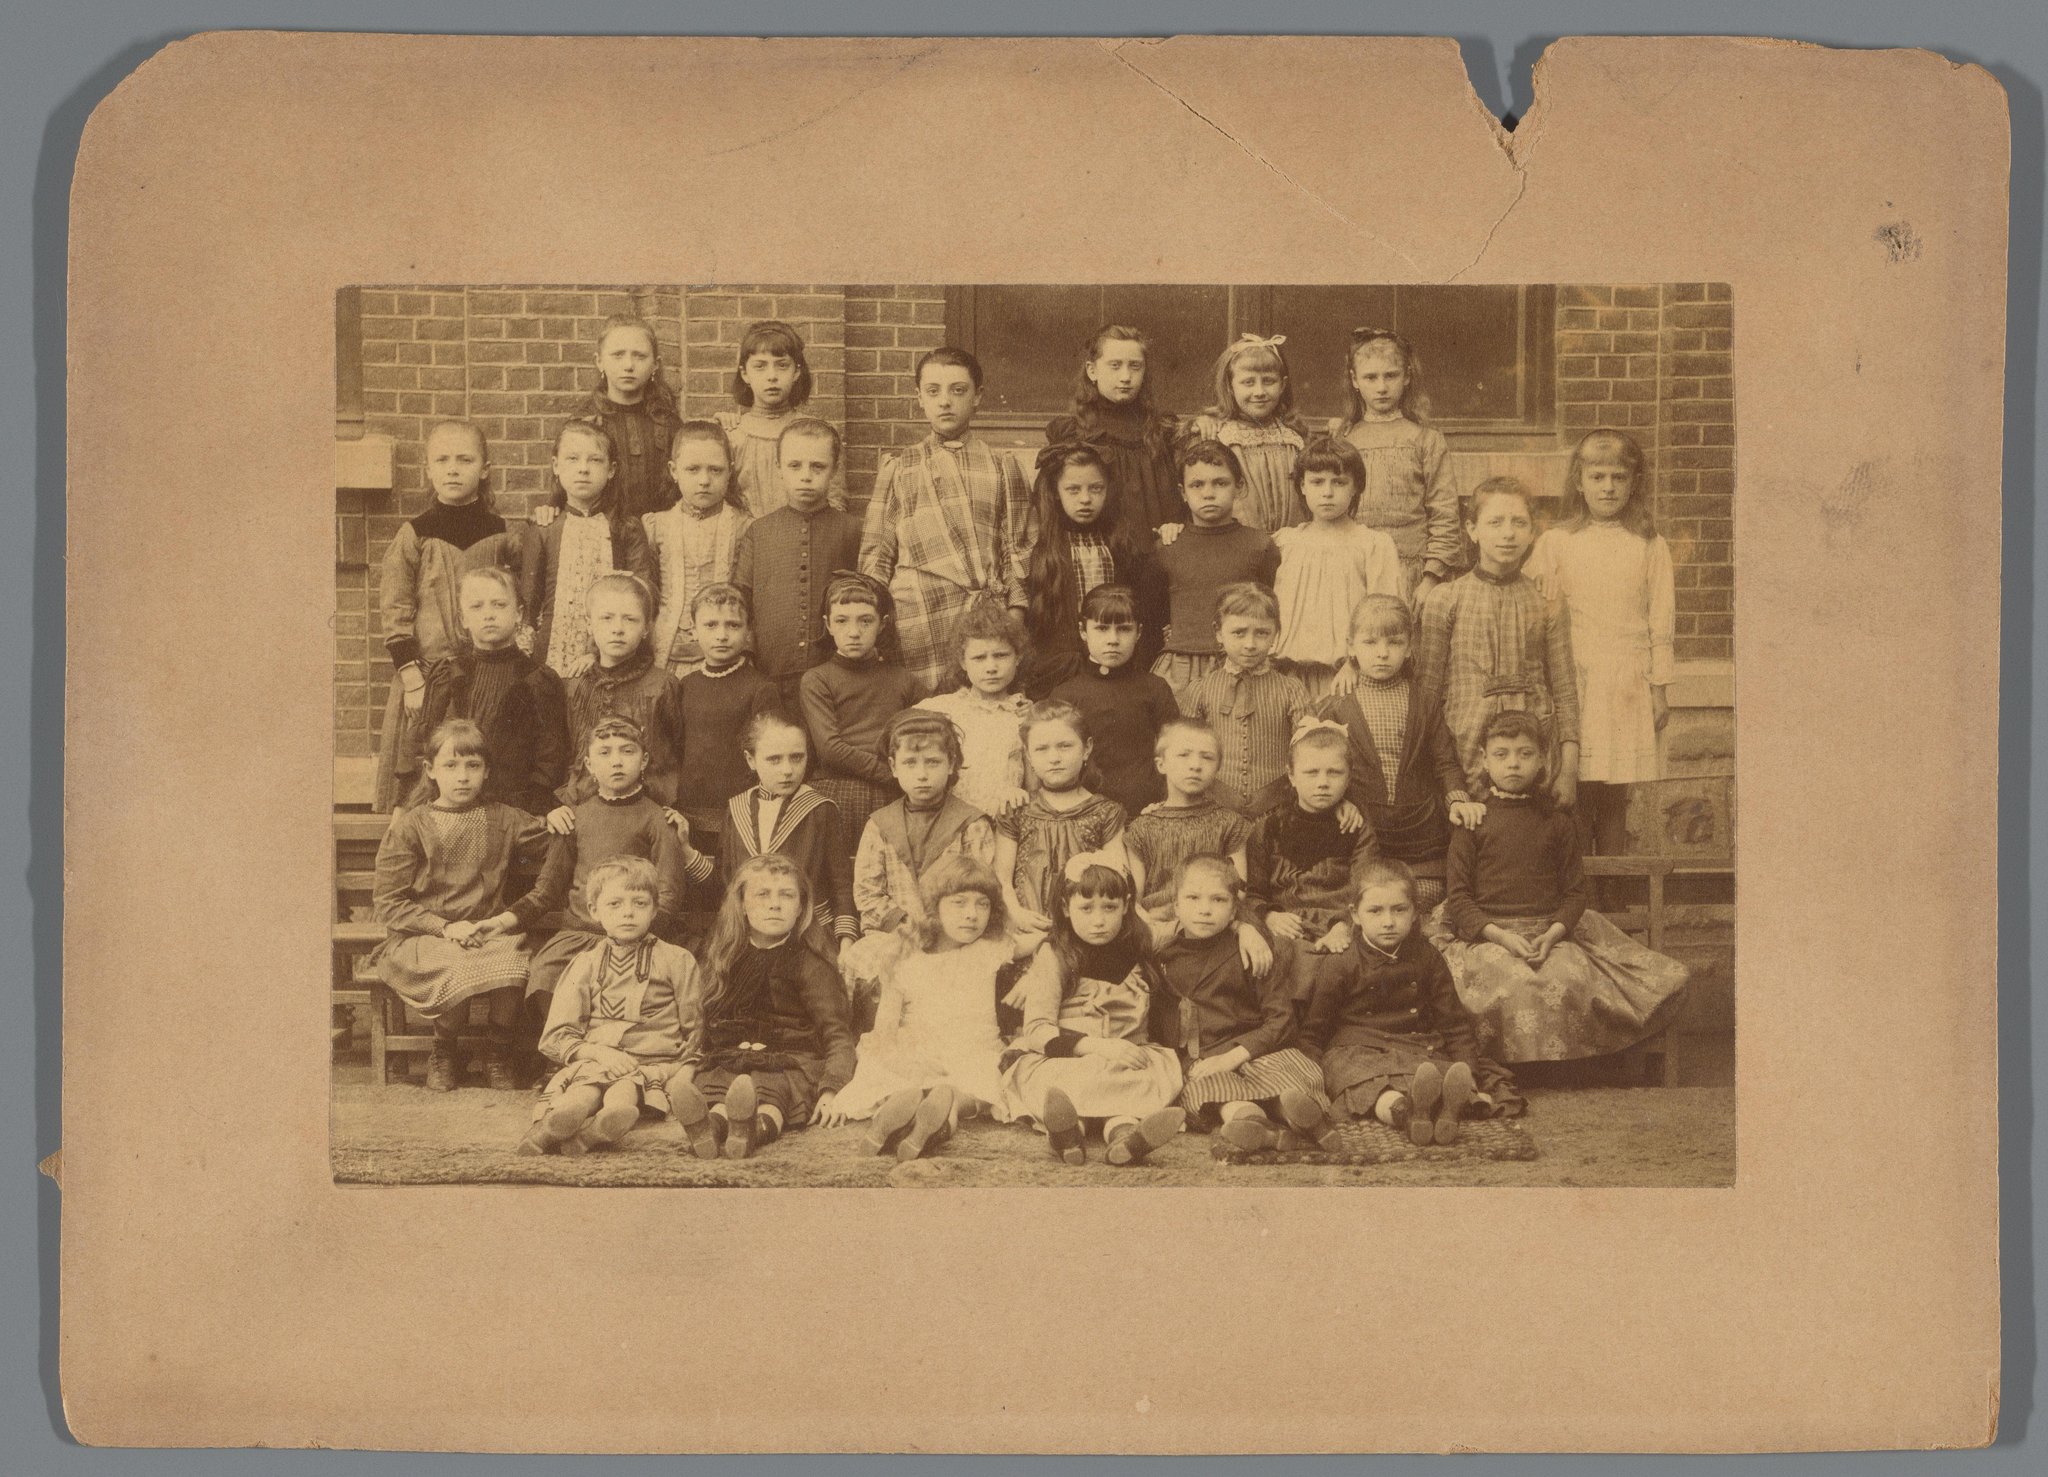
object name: photograph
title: Groepsportret van een onbekende schoolklas, mogelijk Belgisch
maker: Anonymous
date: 1880-1910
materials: paper, cardboard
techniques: gelatin silver print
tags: elementary school; class, form, anonymous historical persons portrayed in a group, in a group-portrait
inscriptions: inscription: ‘gekocht vlooienmarkt Brussel jrt 1961 Bfr 5,-’